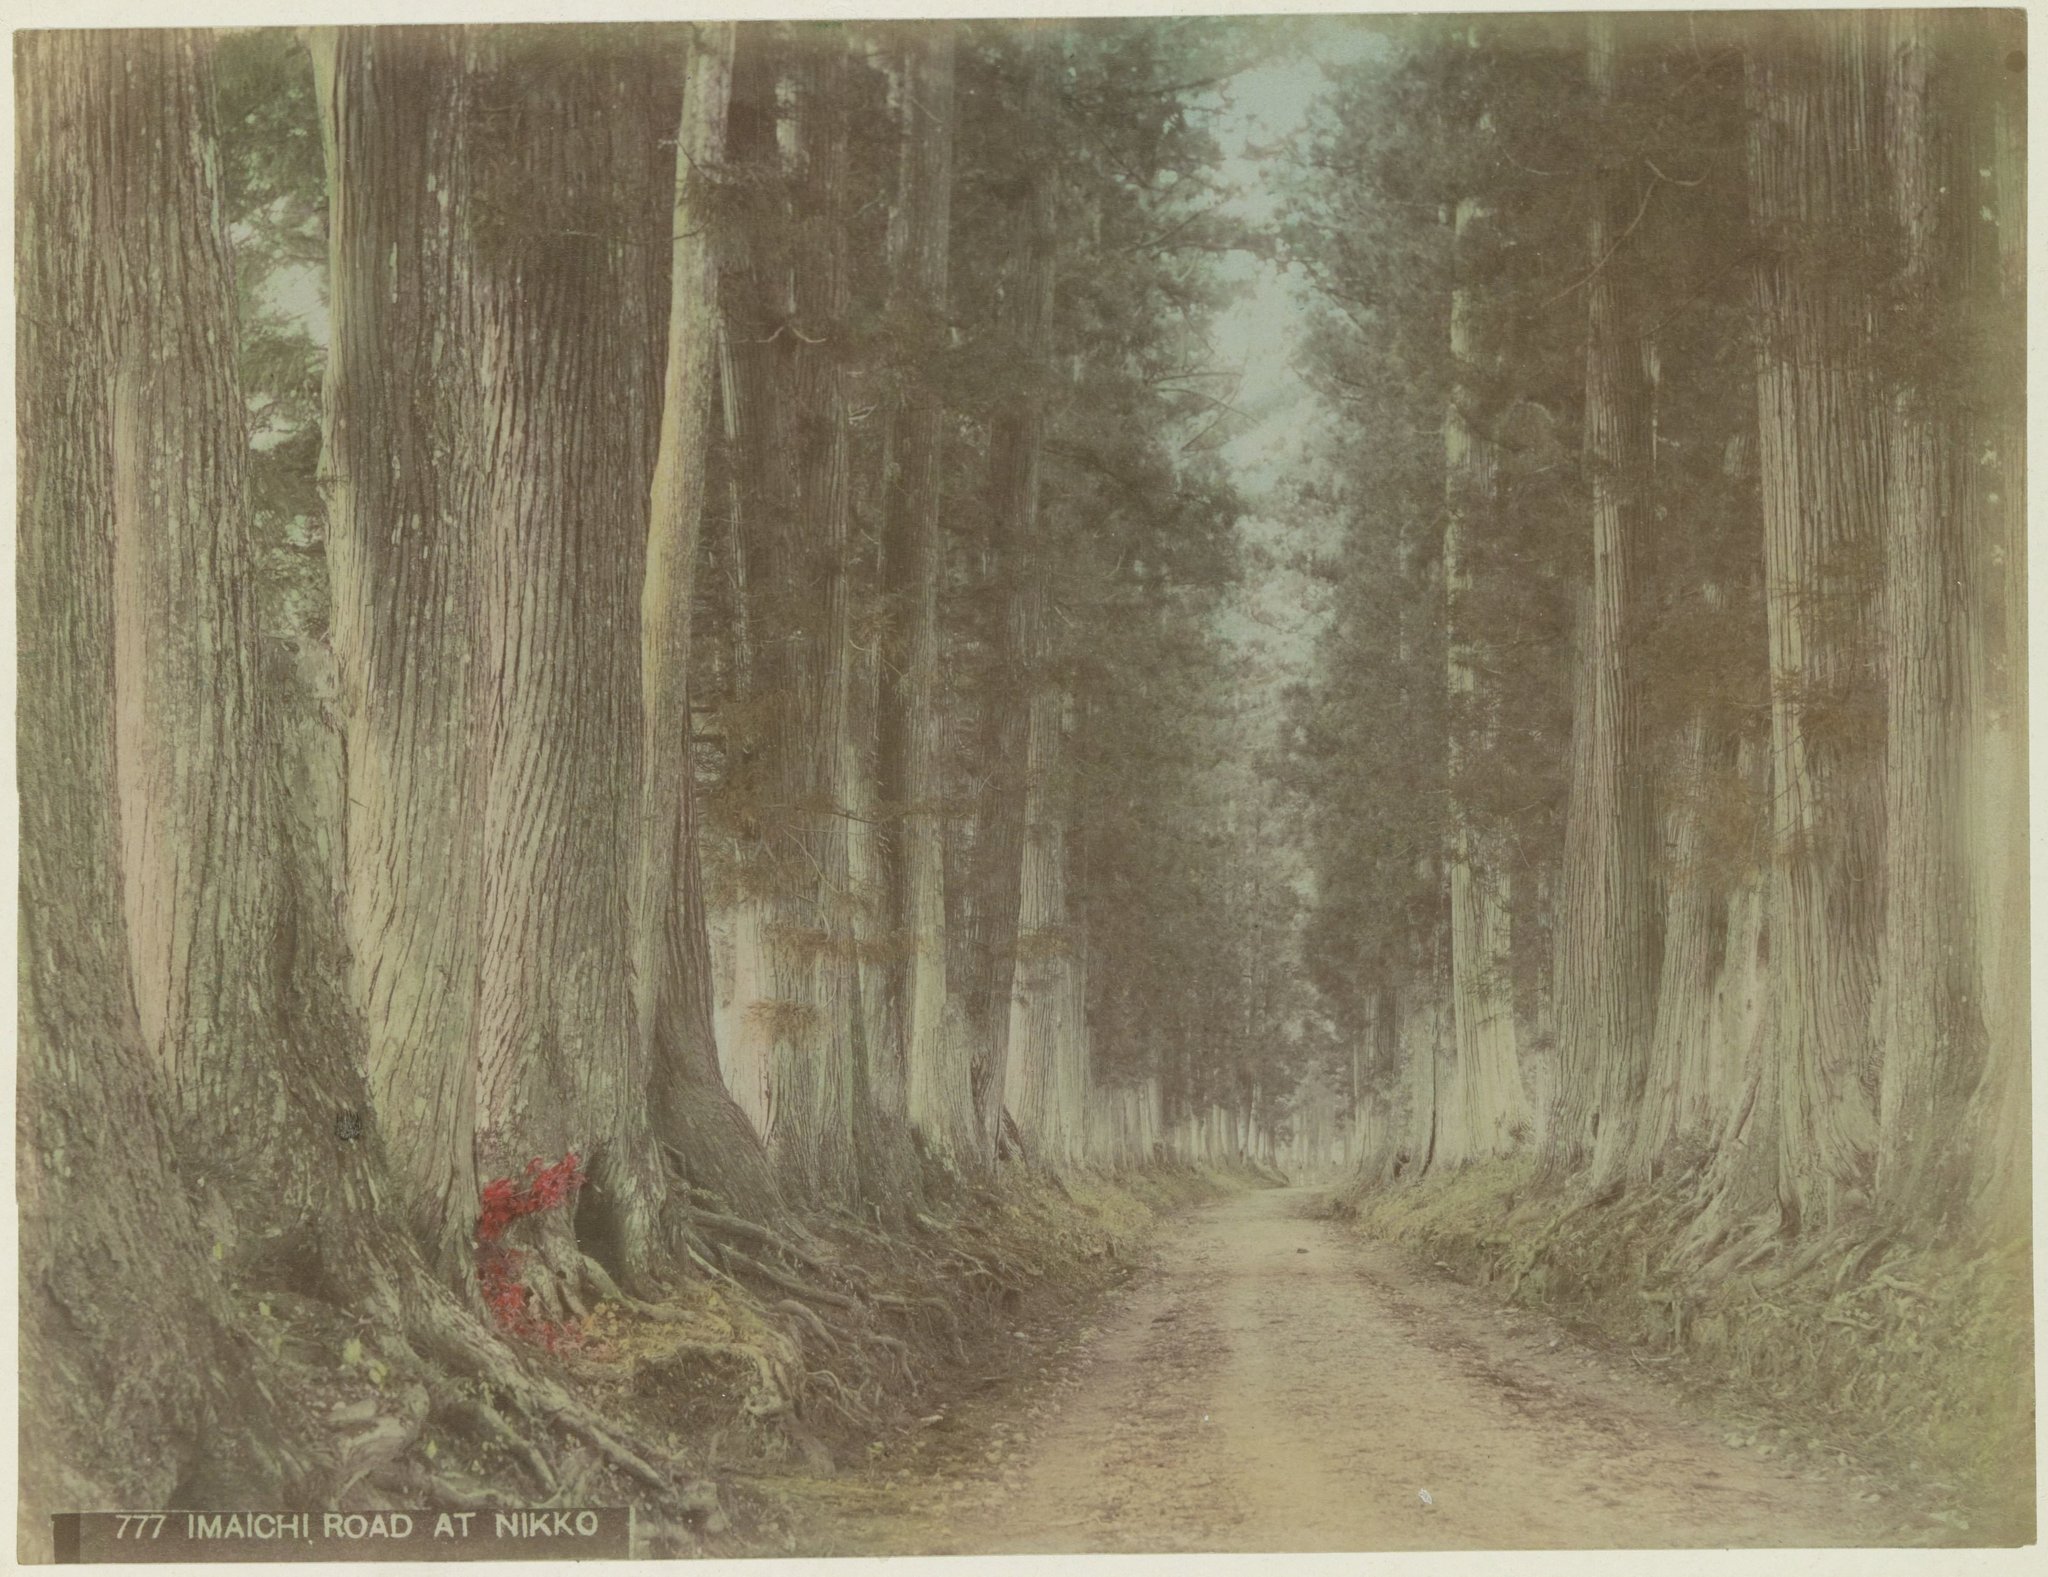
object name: photograph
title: Imaichiweg in Nikko met aan weerszijden bomen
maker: Anonymous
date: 1870-1900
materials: cardboard, paper, photographic support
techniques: albumen print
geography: nikko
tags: trees, road, path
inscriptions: negative number: ‘777’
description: Onderdeel van Reisalbum met foto's van bezienswaardigheden in Japan.